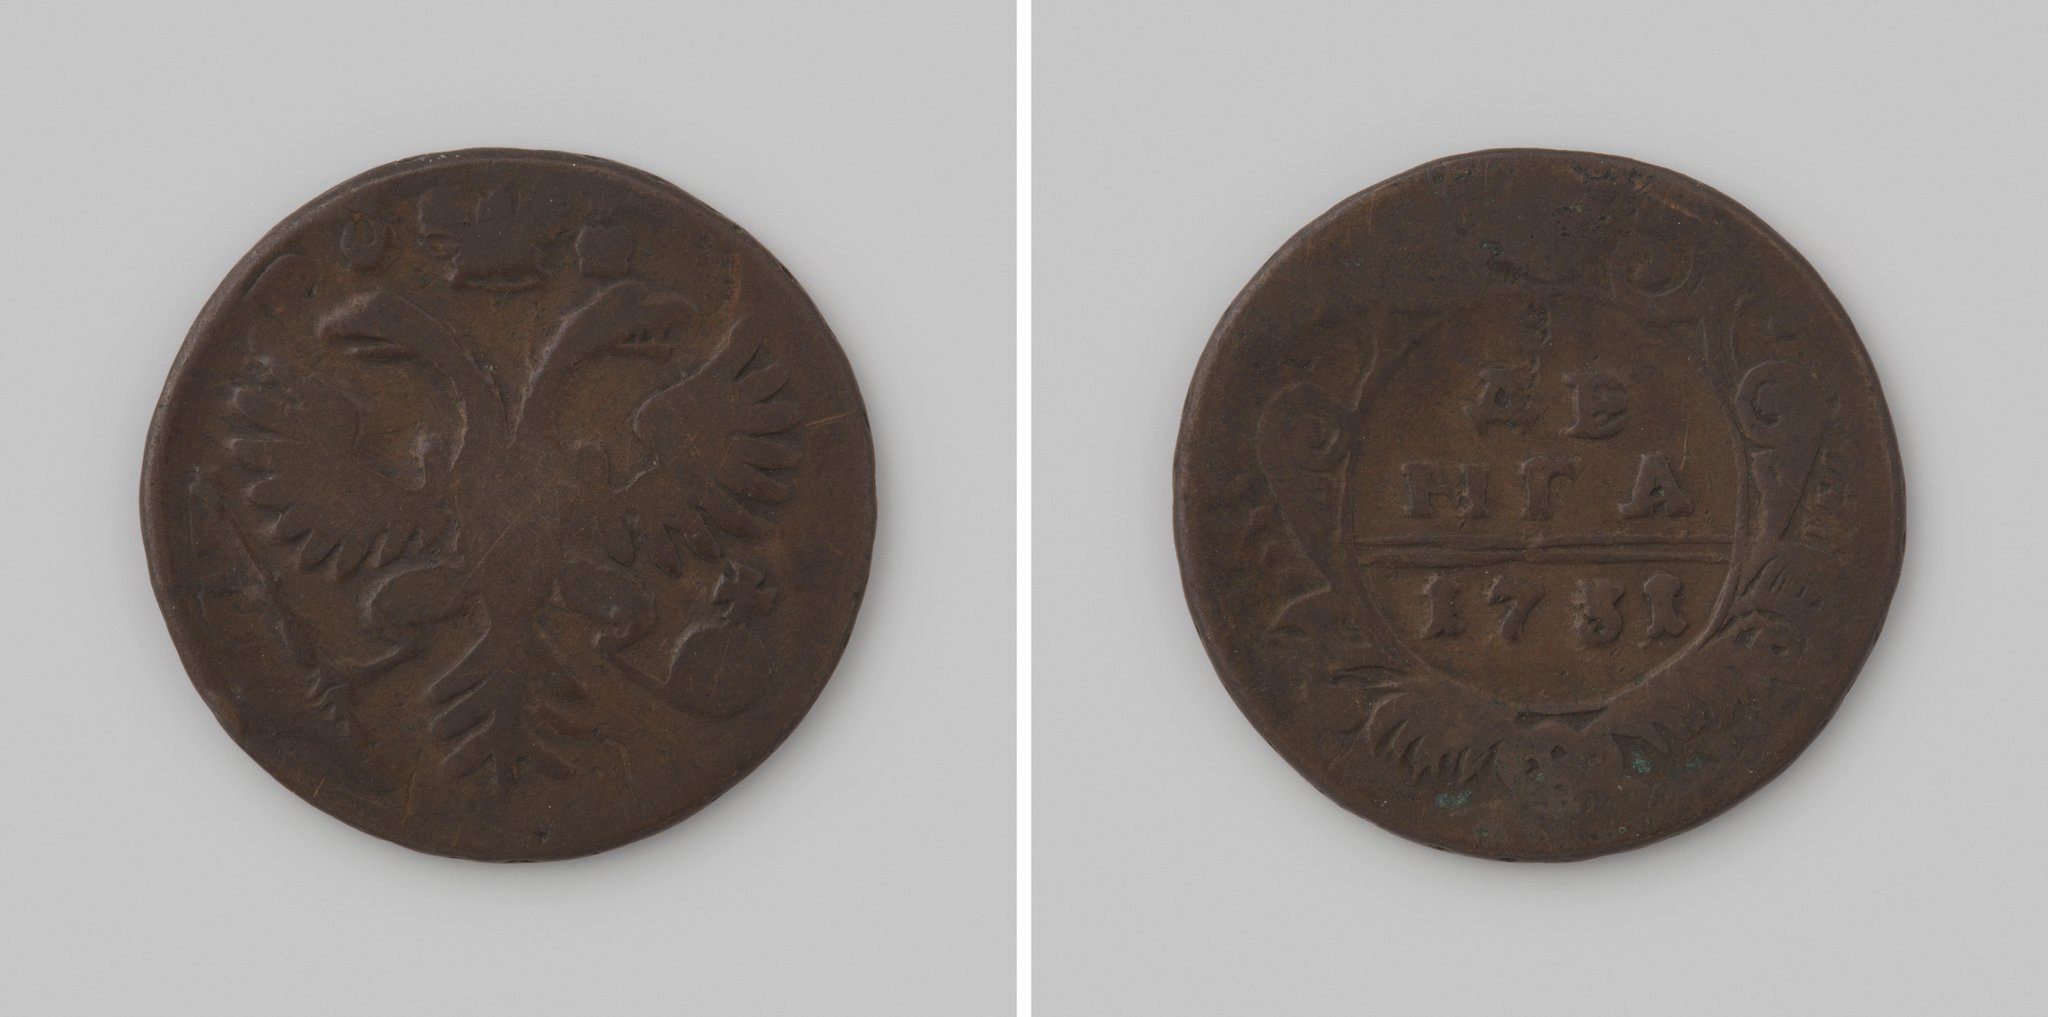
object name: coin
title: Denga uit Rusland van tsarina Anna,1731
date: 1731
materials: copper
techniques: striking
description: Koperen munt. Voorzijde: dubbelkoppige gekroonde adelaar met gespreide vleugels en met in zijn poten scepter en bol met daarop kruis. Boven de adelaar een kroon. Keerzijde: binnen barok-versiering waarde-aanduiding in twee regels, waaronder jaartal. Kabelrand.